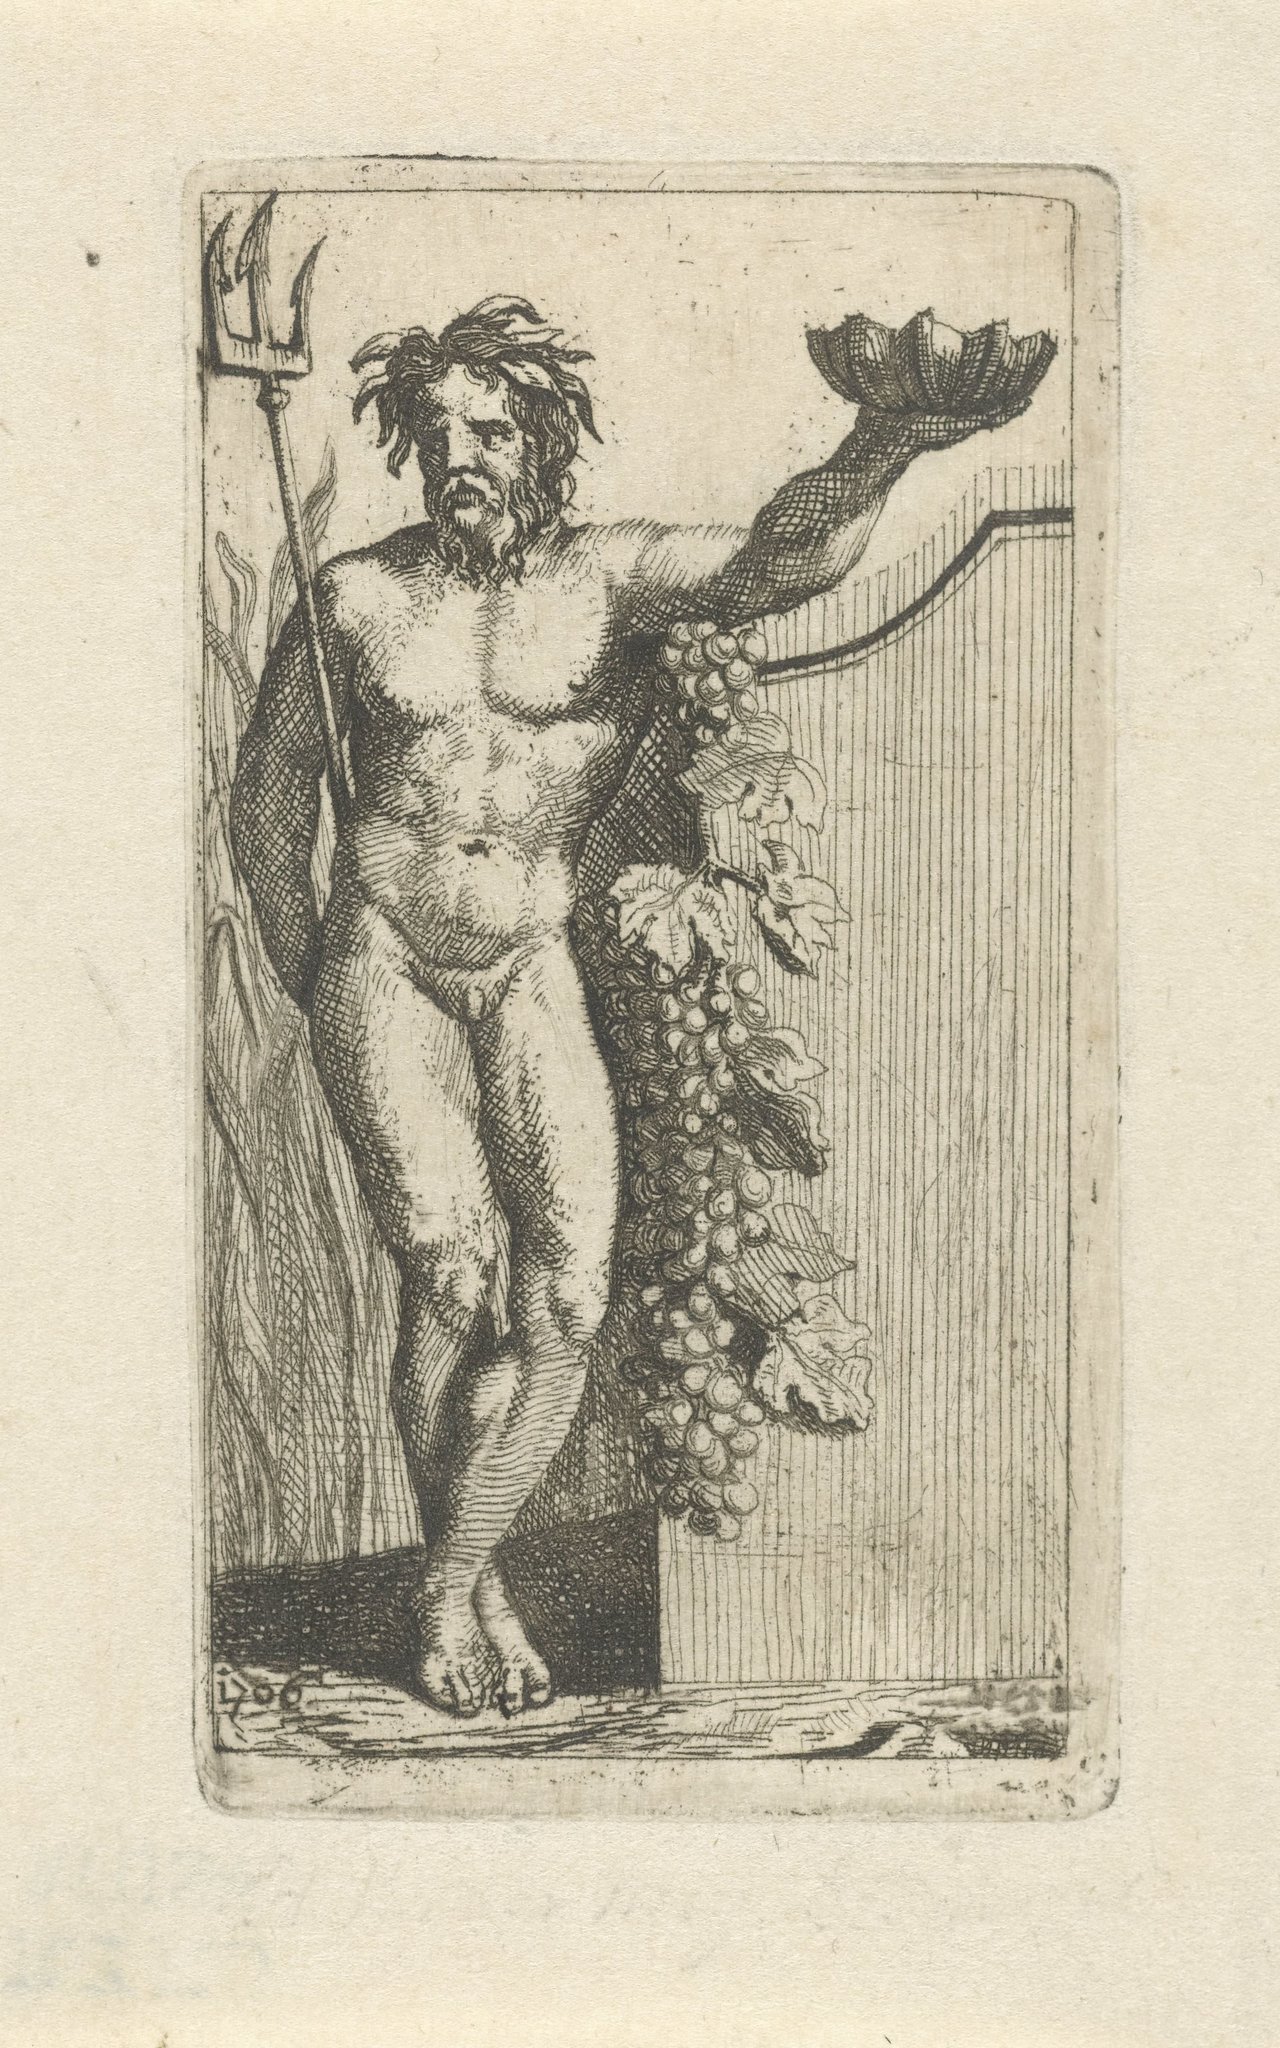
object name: print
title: Neptunus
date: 1724-1777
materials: paper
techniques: etching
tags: (story of) neptune (poseidon)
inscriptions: collector's mark: Lugt 2165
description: Staande Neptunus met drietand en een door hem omhoog geheven schelp. Linksonder: 1706.